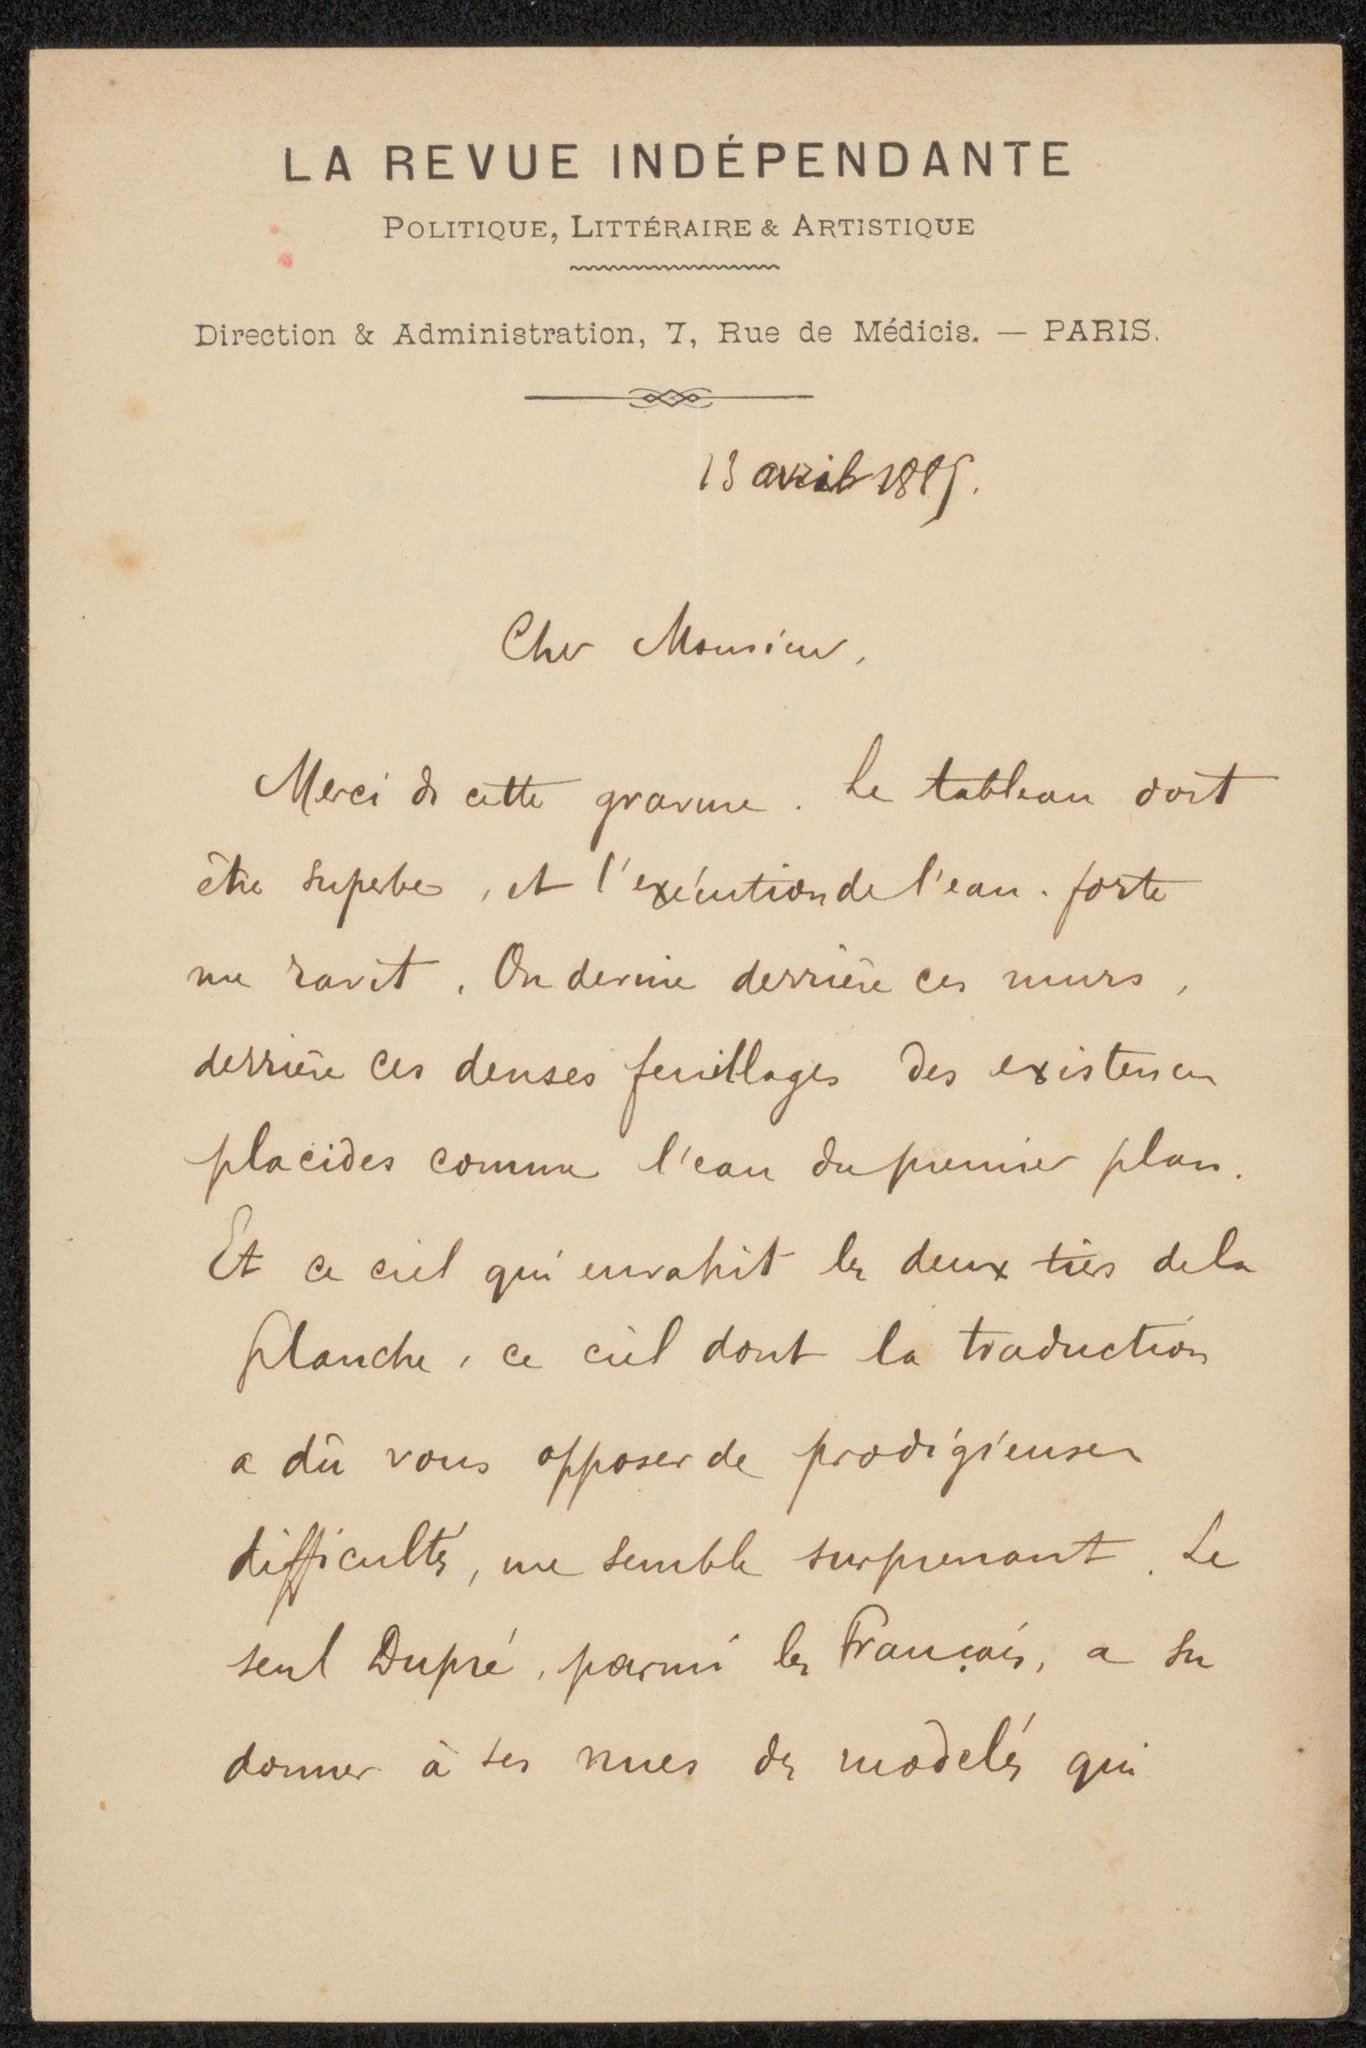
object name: letter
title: Brief aan Philip Zilcken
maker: félix fénéon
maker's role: handelaar, kunstcriticus, verzamelaar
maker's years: 1861-1944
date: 1885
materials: ink, paper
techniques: pen, printing, writing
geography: paris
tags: delft, johannes vermeer, the hague, painter, draughtsman, philip zilcken, the graphic arts, painting (including book-illumination, miniature-painting)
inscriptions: collector's mark: ‘RPK’